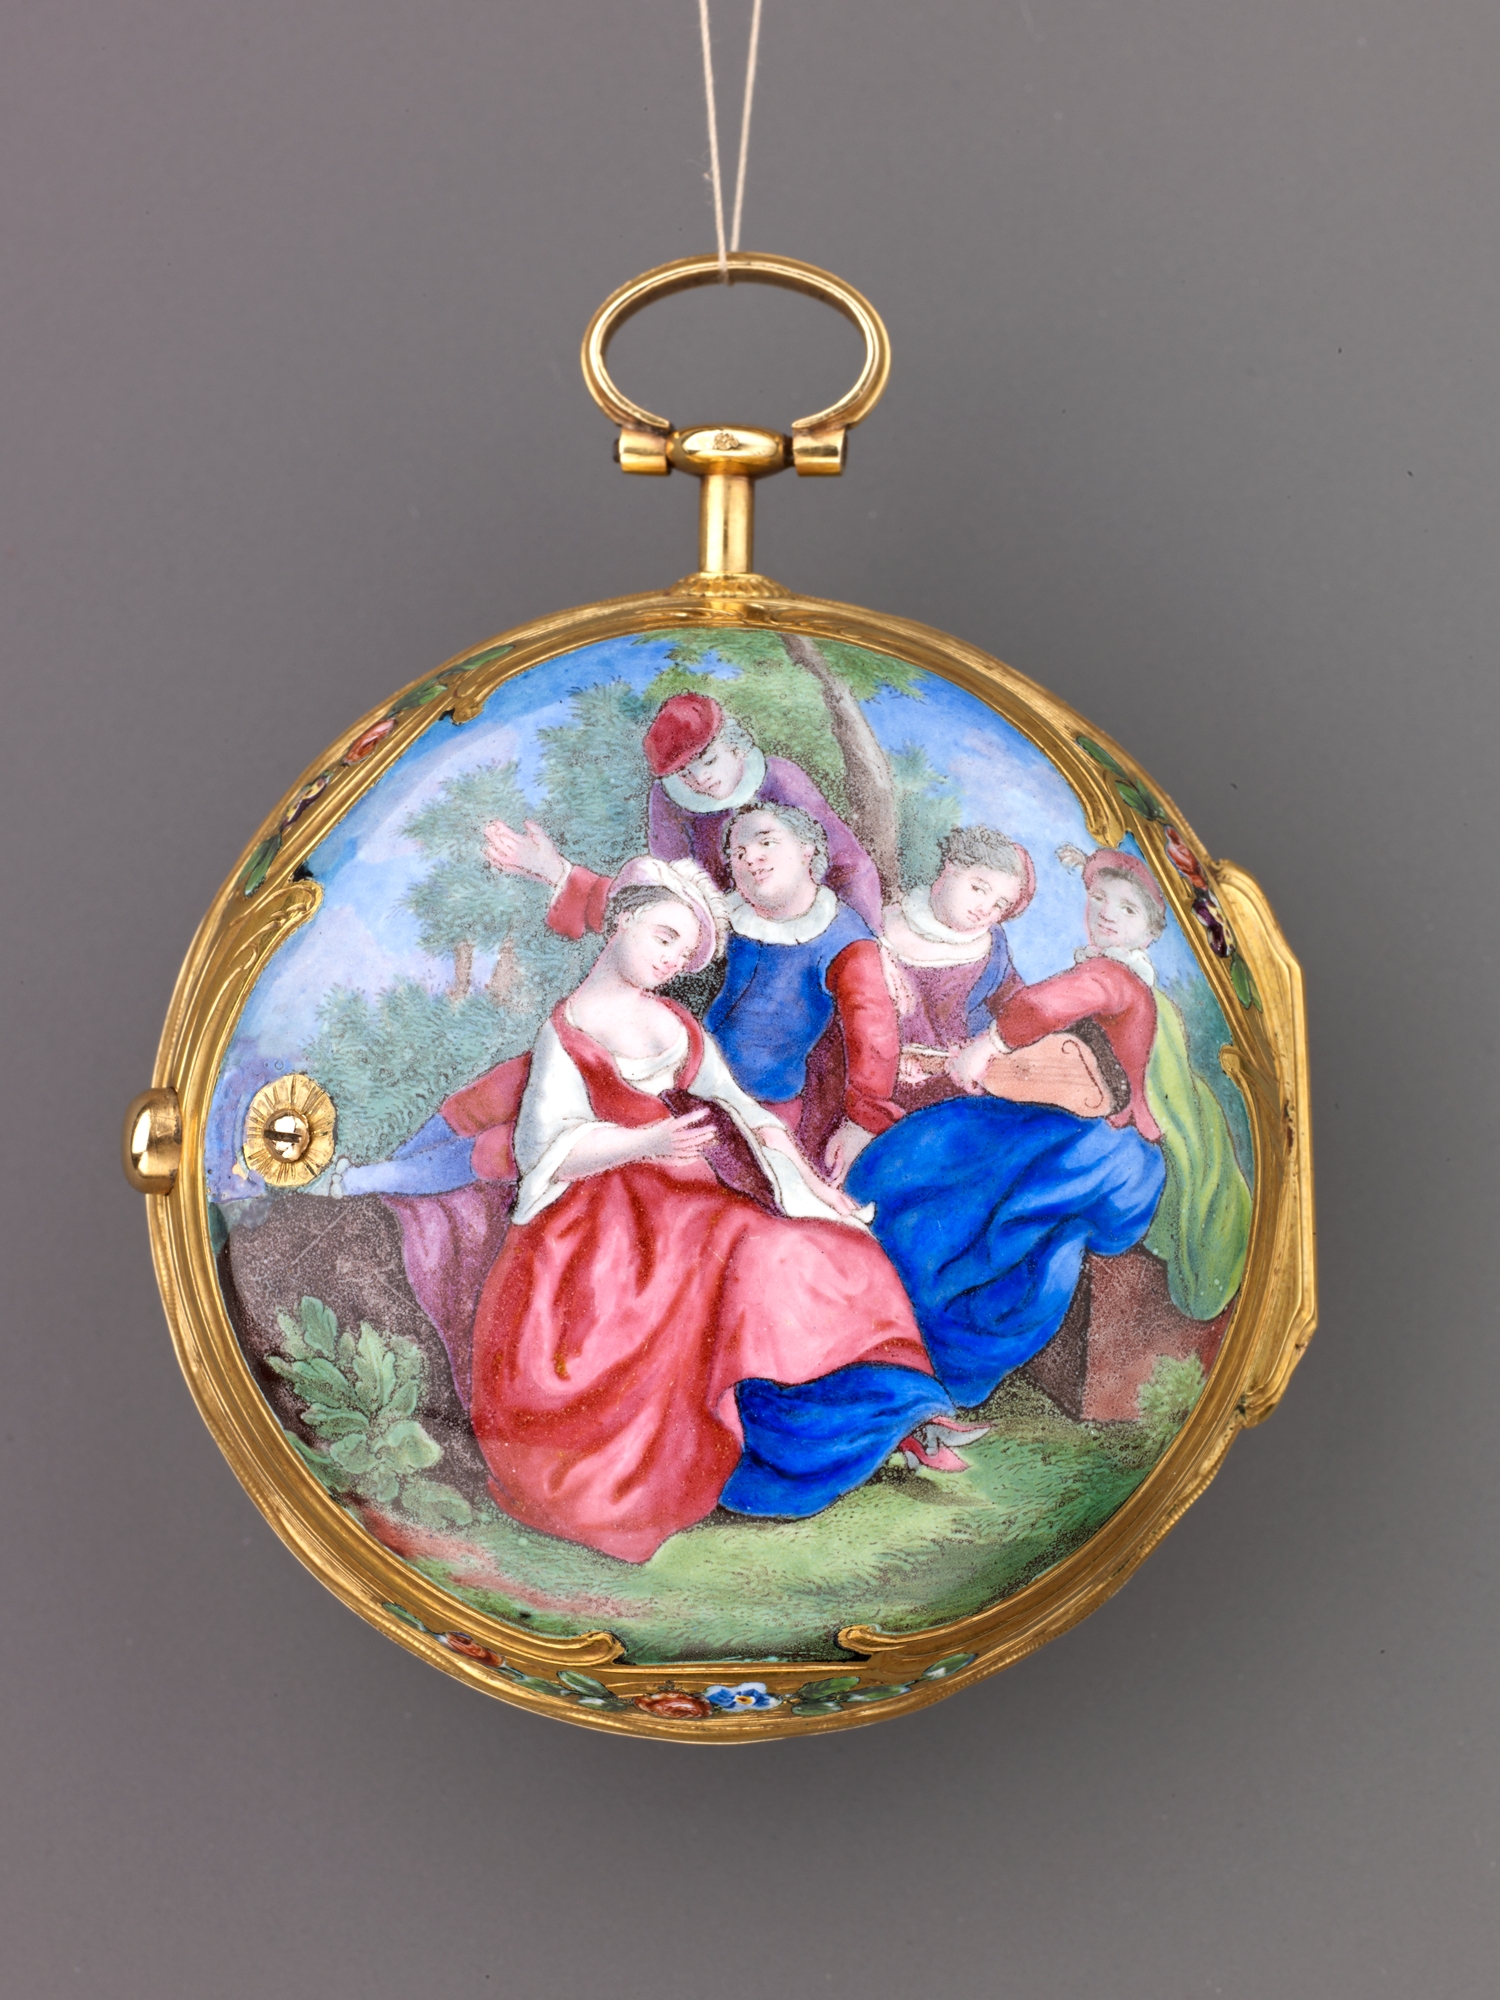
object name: watch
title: Watch Painted with a Pastoral Scene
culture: french or swiss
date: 1758-1765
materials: brass, diamond, enamel, gilt, gold, silver, steel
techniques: painting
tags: musical instruments,men,women,musicians